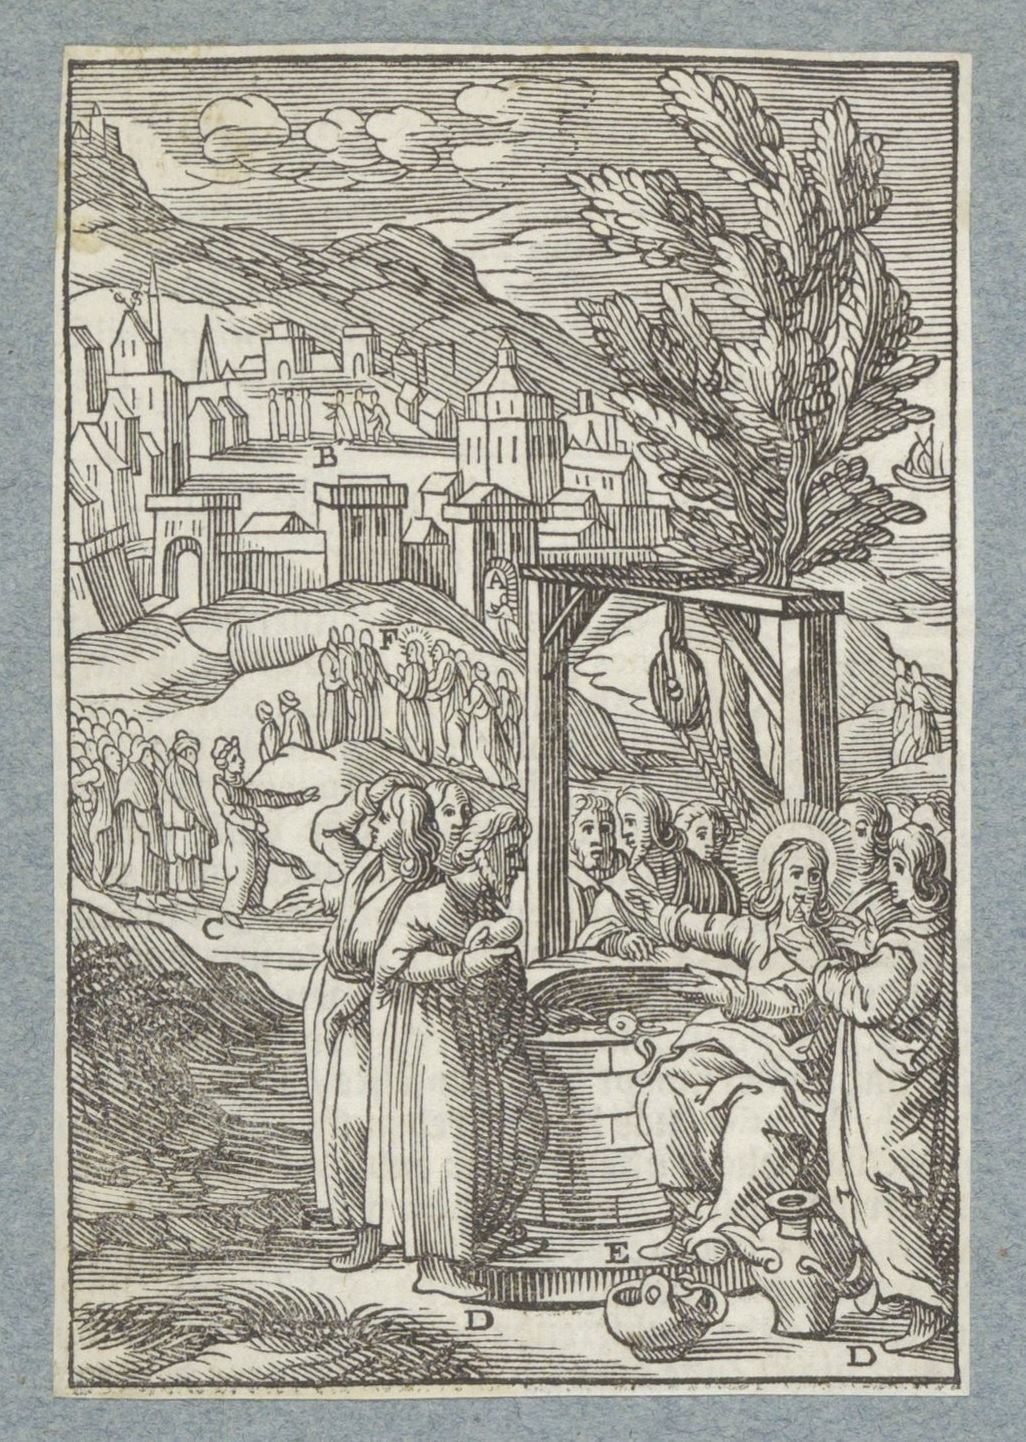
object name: album leaf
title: Christus en zijn leerlingen bij de put in Sichar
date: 1629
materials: paper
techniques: letterpress printing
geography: amsterdam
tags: christ's disciples returning from sychar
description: De prent is afkomstig uit een van de uitgaven van P.J. Paets uit Amsterdam. De prent wordt voor het eerst gebruikt in: Der Zielen Lust-hof. Leuven, I.Jacbosz voor P.J. Paets [= Amsterdam, P.J. Paets], 1629. De voorstelling is gekopieerd naar een prent van Antonie II Wierix voor: Nadal, Jerónimo. Evangelicae Historiae Imagines. Antwerpen, M. Nutius, 1593.